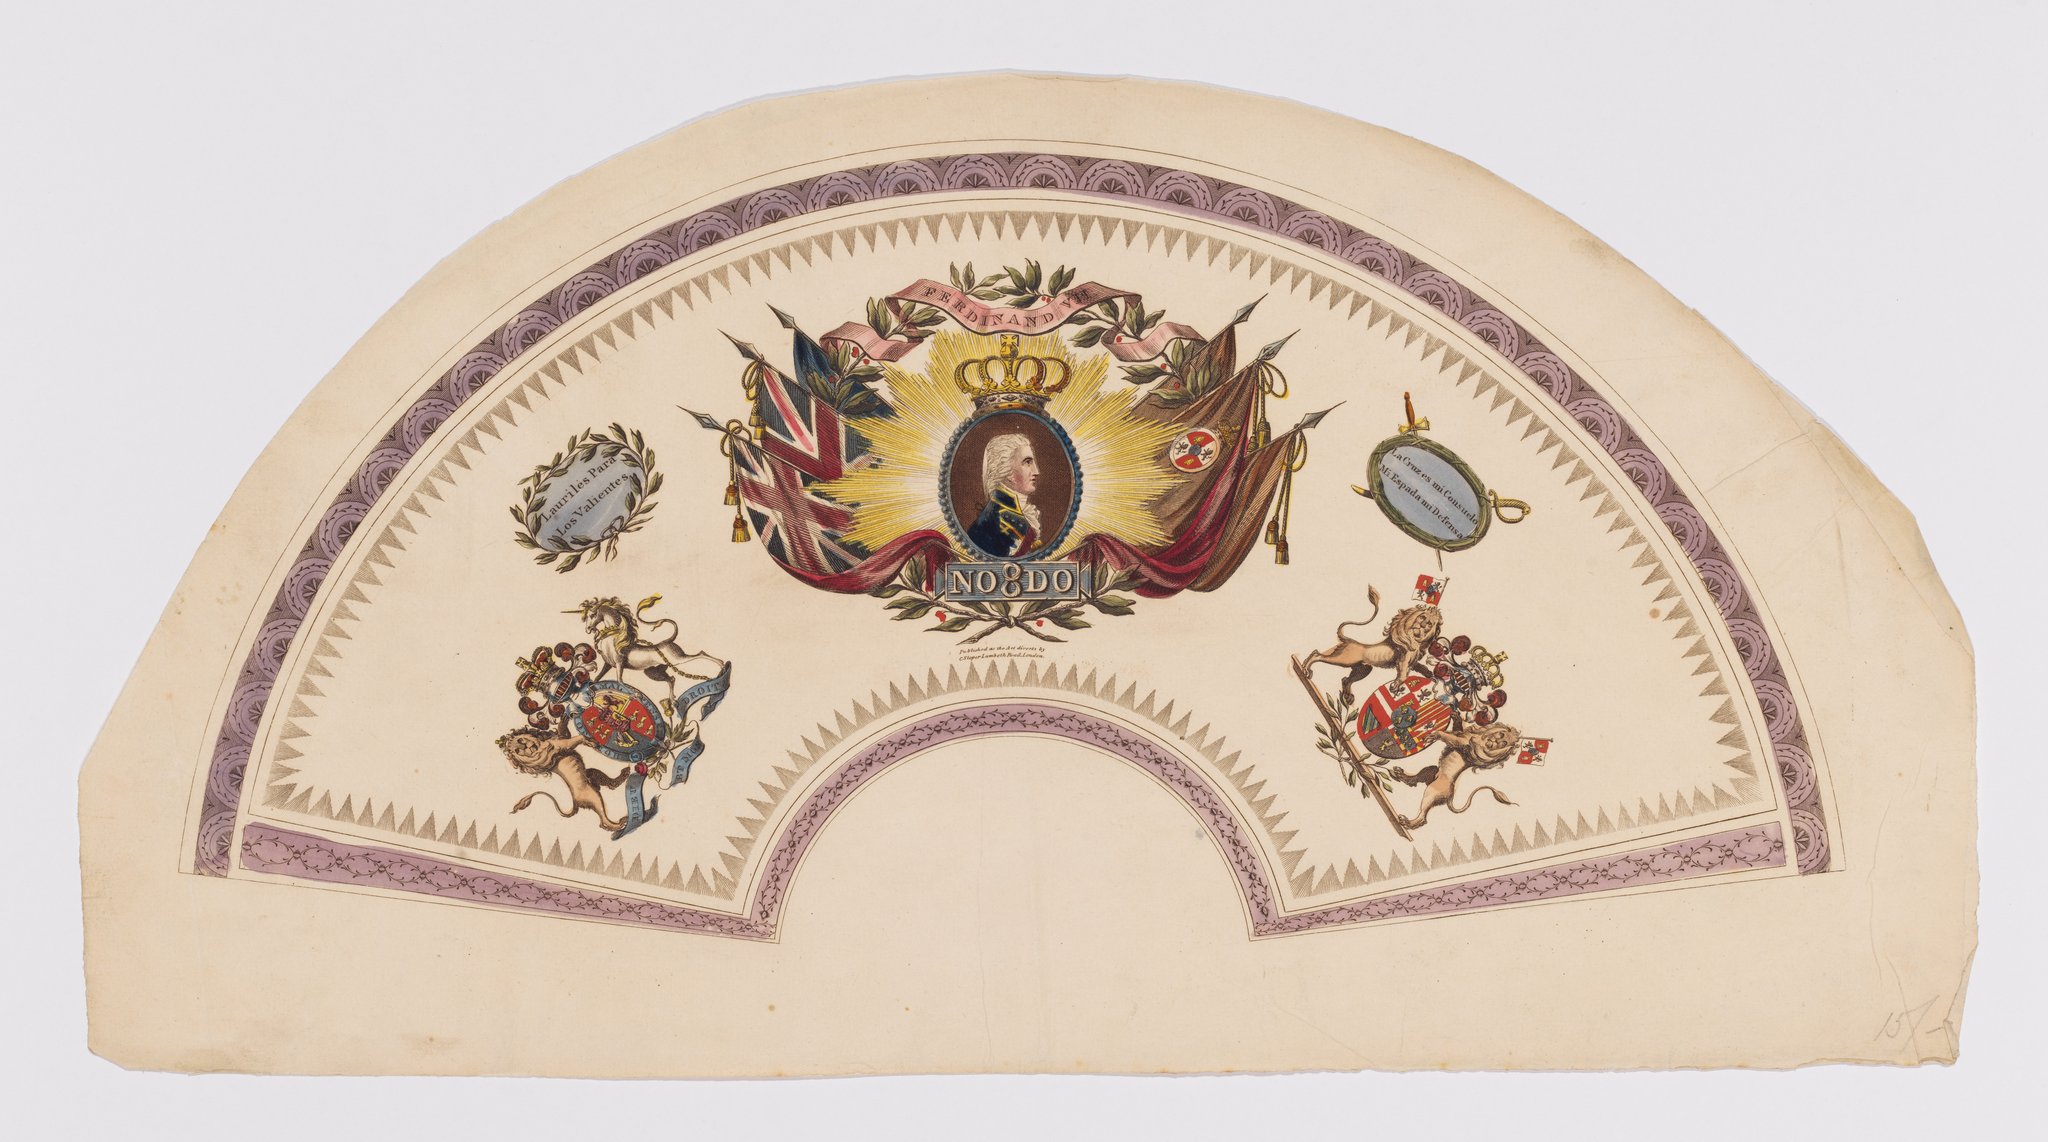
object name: print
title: Fan design in honor of Ferdinand VII, King of Spain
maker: anonymous, british, 19th century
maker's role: artist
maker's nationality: british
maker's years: 1800-1900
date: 1814-1815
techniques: engraving, hand coloring